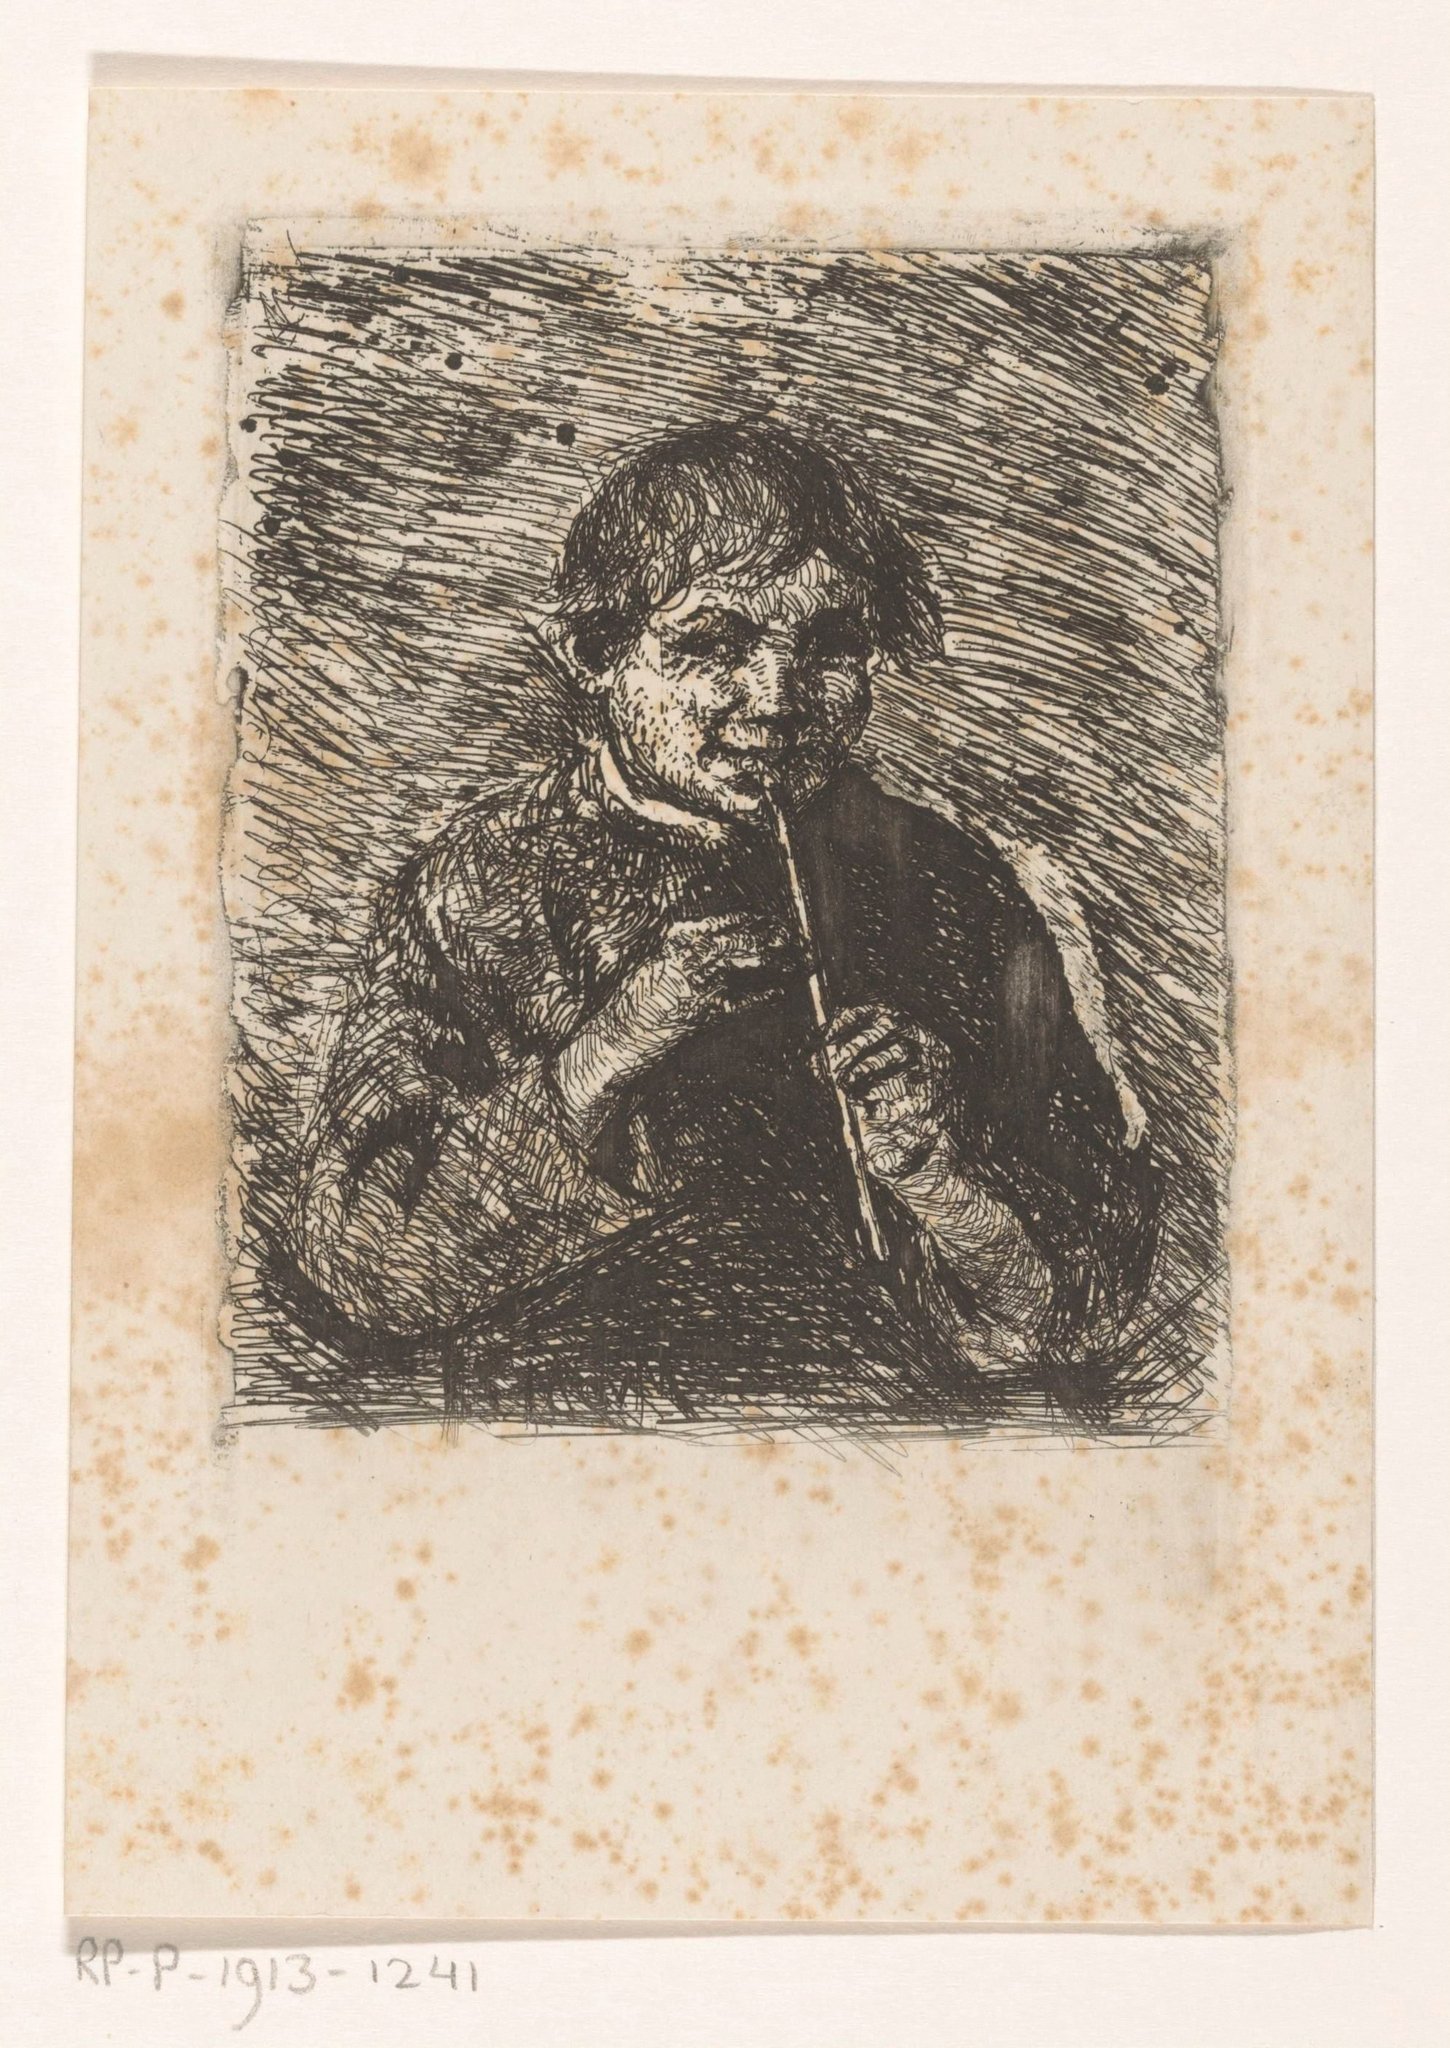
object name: print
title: Fluitspelende jongen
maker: marinus van der maarel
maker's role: draughtsman, painter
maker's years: 1857-1921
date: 1867-1913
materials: paper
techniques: etching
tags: one person playing wind instrument, boy (child between toddler and youth), flute, aulos, tibia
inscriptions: collector's mark: Lugt 2228, collector's mark: Lugt 2233